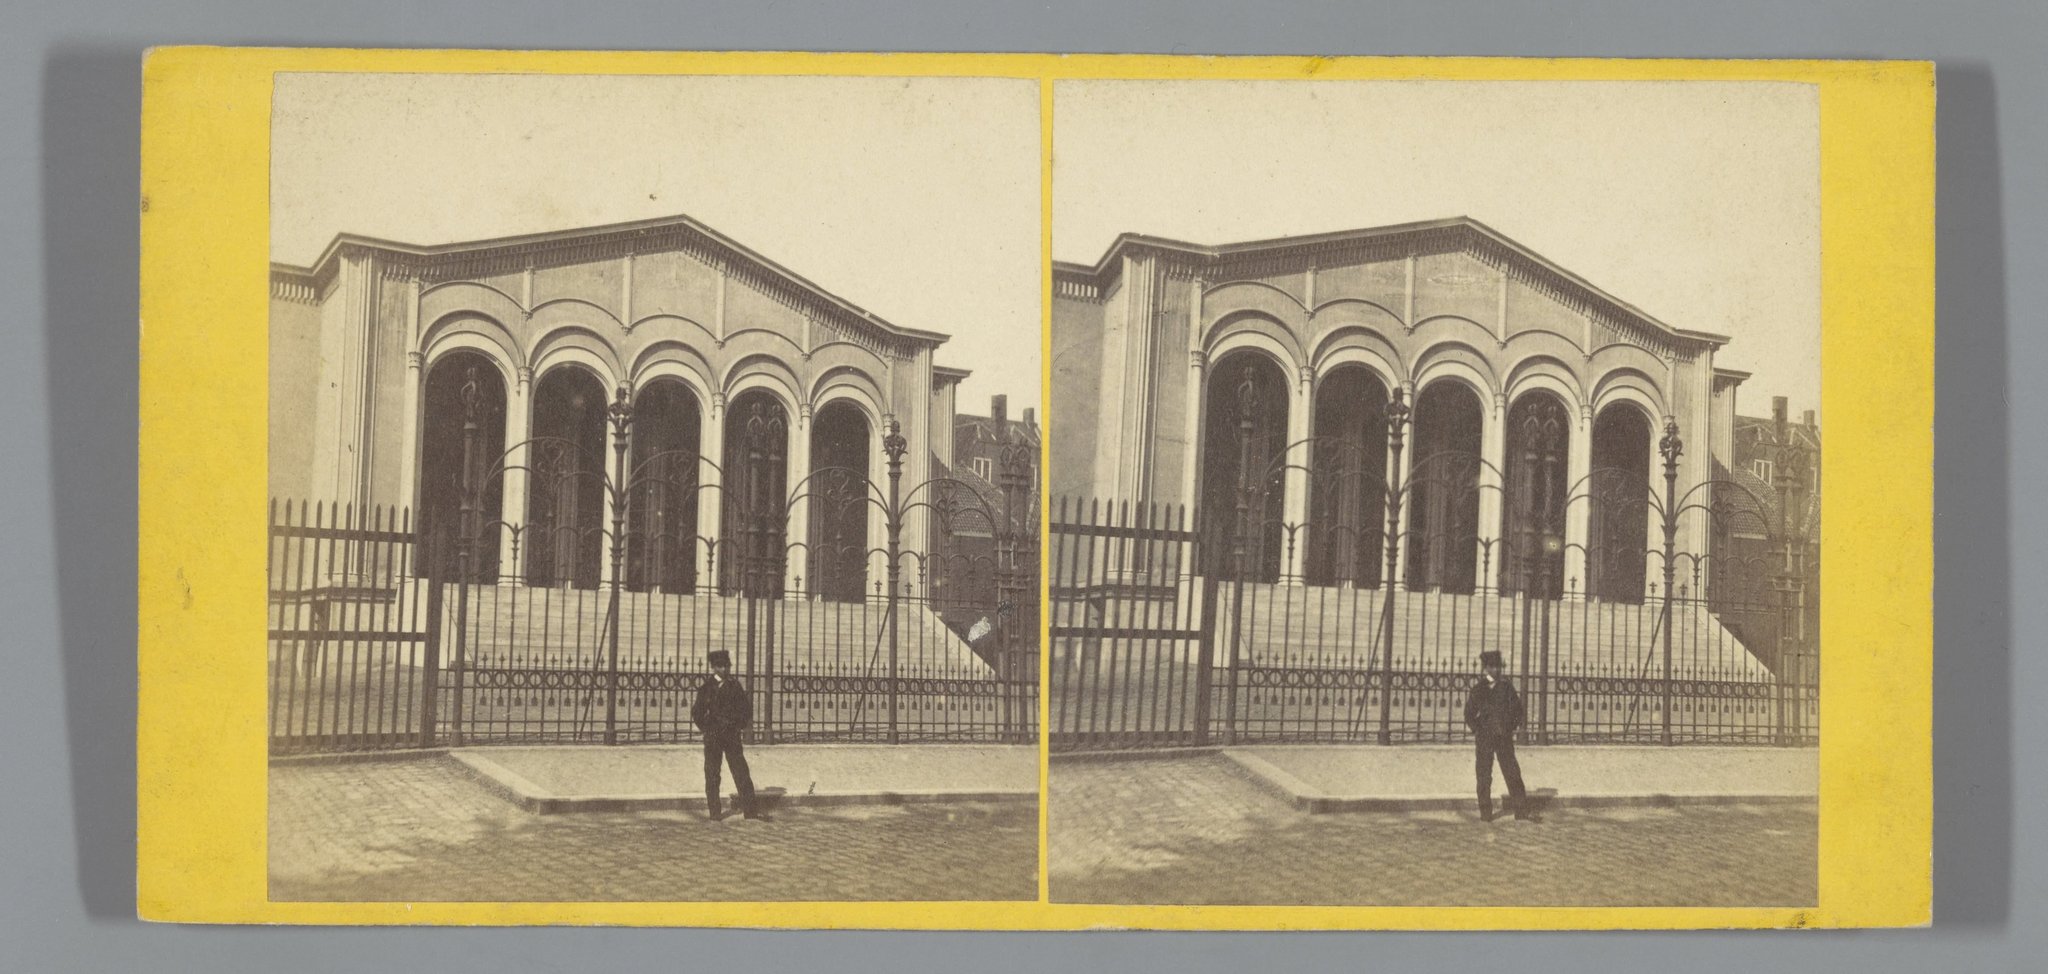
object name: stereograph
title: Gezicht op het gebouw van de Hoge Raad aan het Plein in Den Haag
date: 1860-1885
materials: cardboard, photographic support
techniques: albumen print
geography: the hague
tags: court building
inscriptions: annotation: ‘'s Gravenhage./ Gebouw voor den Hoogen Raad.’, inscription: ‘Uitgegeven bij A. JAGER, Water 110, te Amsterdam.’, annotation: ‘1220’